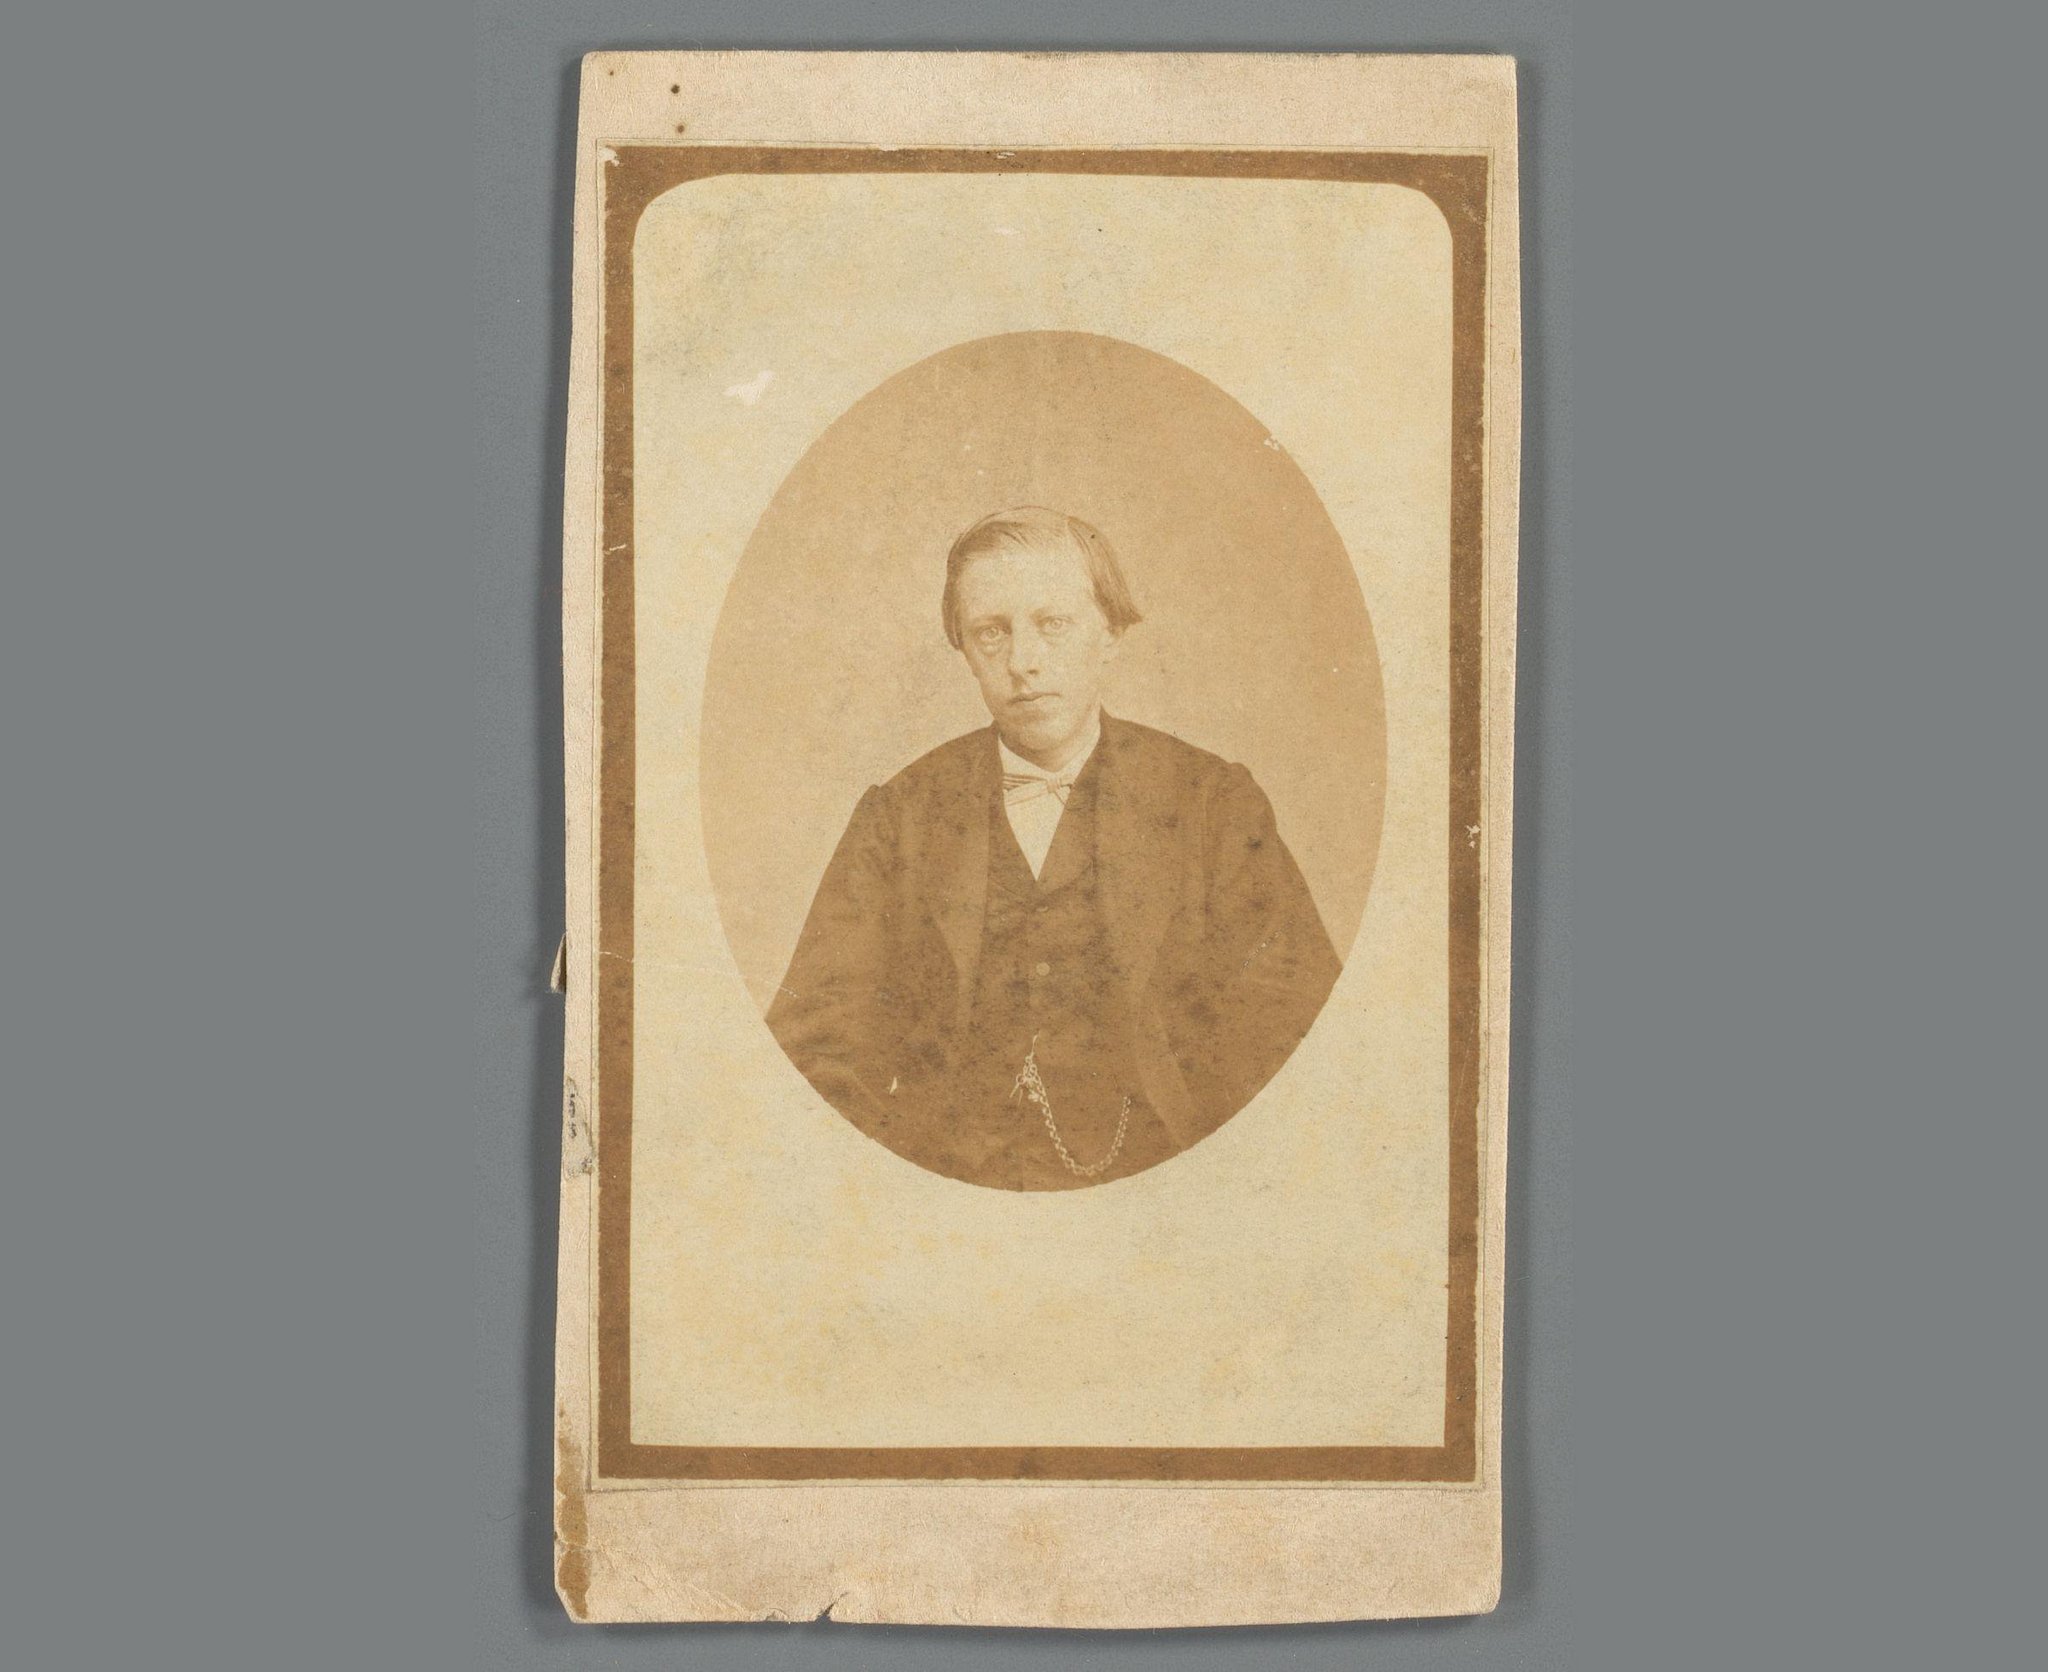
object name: prayer card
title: Portret van Louis Jacques Marie van Aerschodt op bidprent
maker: Anonymous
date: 1867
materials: cardboard, paper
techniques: albumen print, letterpress printing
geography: leuven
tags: louvain, adult man, historical persons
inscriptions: inscription: ‘O croix sainte! Sous ton ombre je repose et j'espère. (...) R.I.P./ Typ. de la veuve ICKX et Fils.’